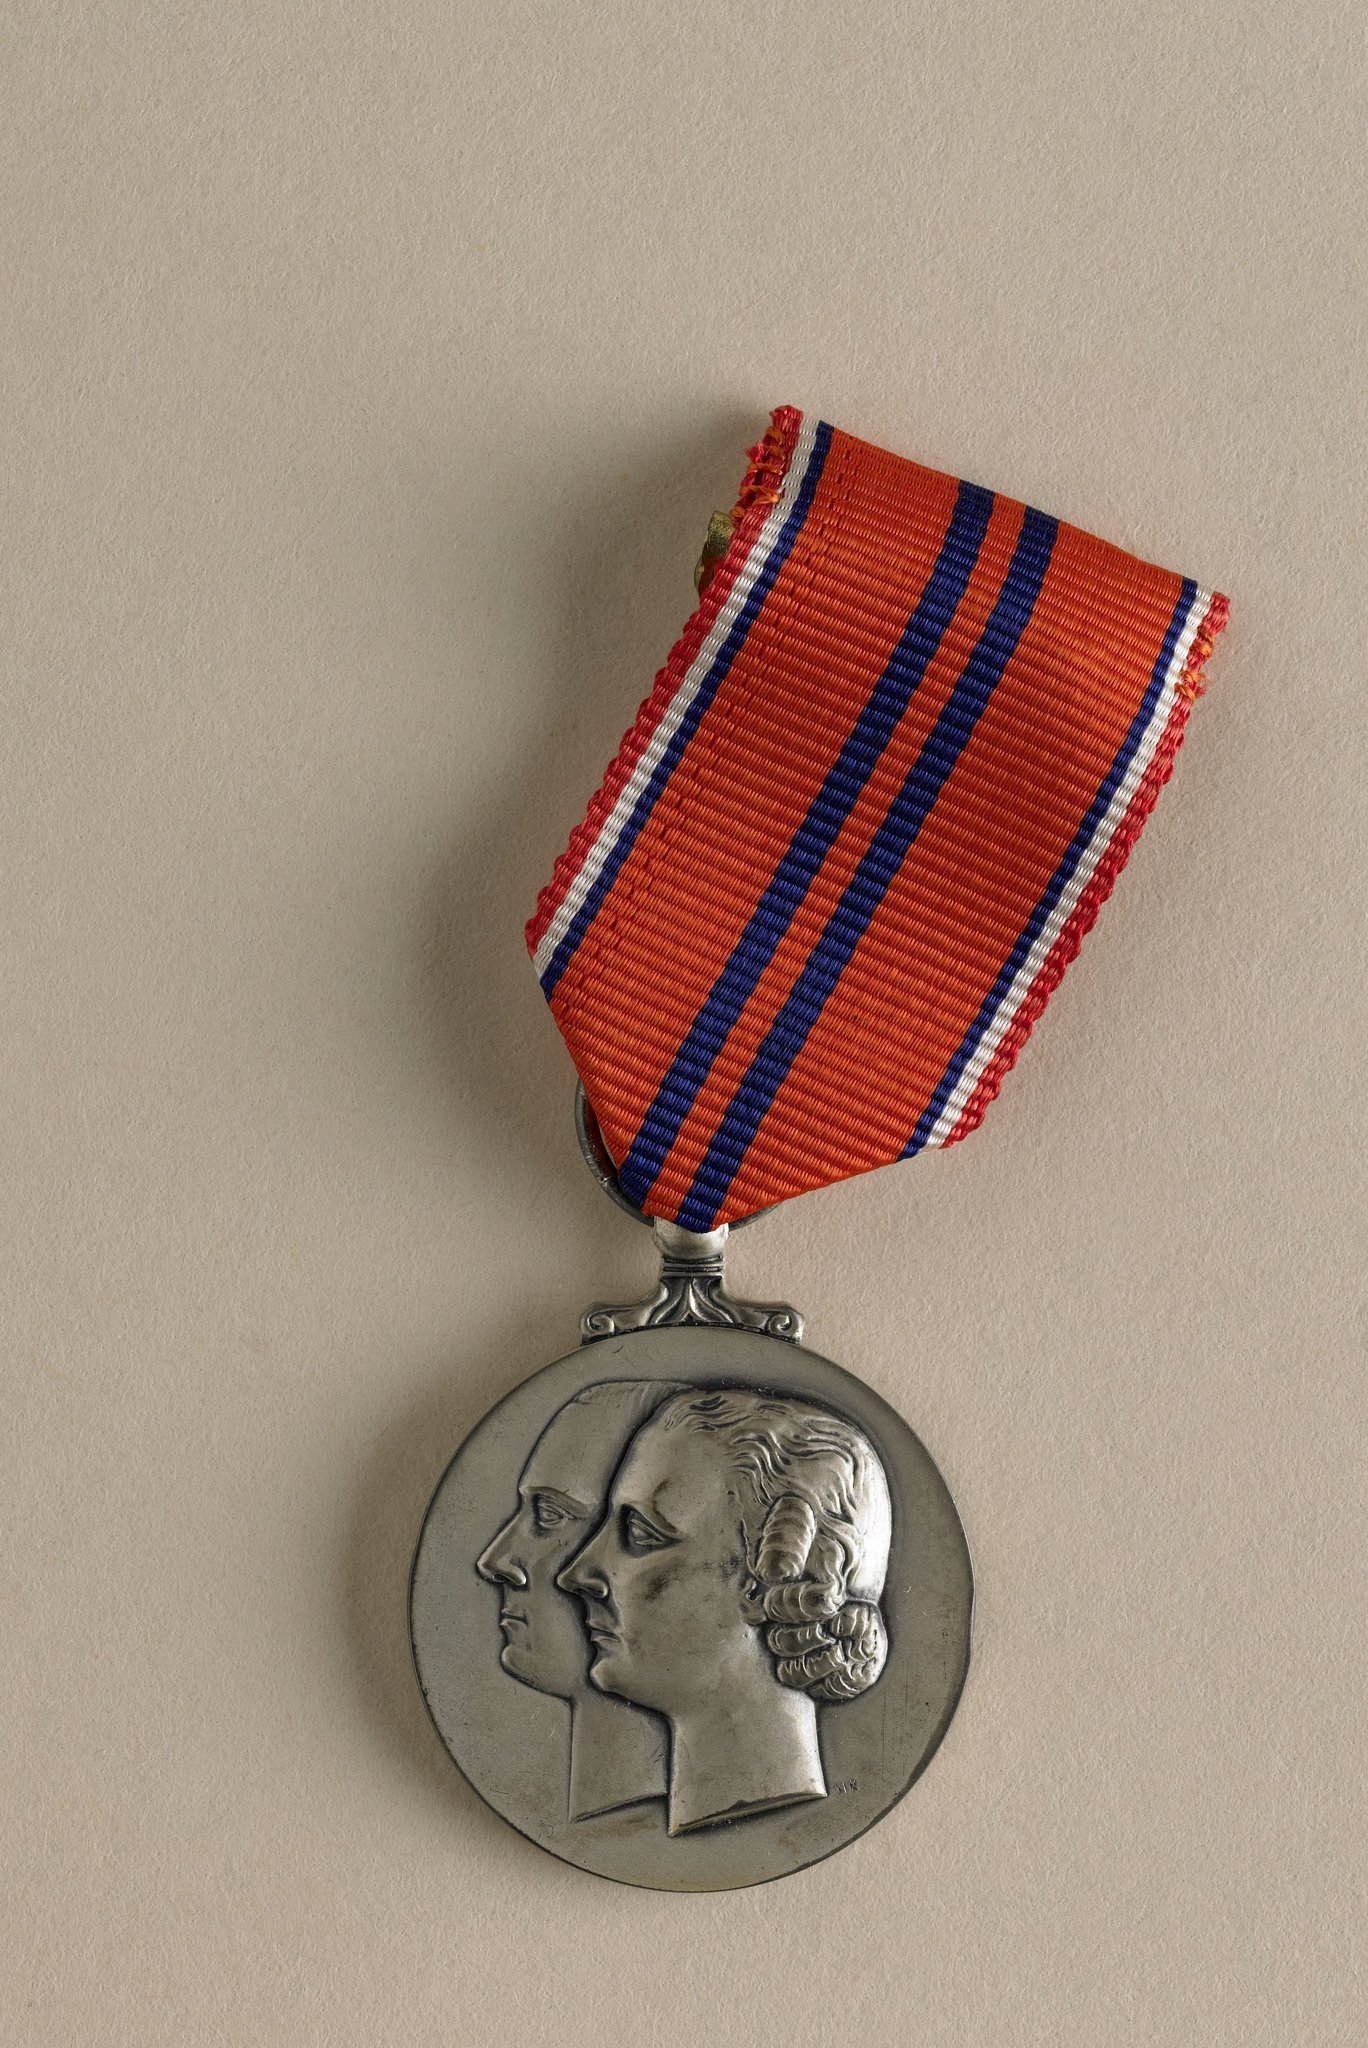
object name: onderscheidingsteken, onderscheiding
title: Inhuldigingsmedaille koningin Juliana 1948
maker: Anonymous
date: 1948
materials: cardboard, silver, textile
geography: netherlands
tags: utrecht, bernhard (prins der nederlanden), willem drees, the hague, juliana of the netherlands, netherlands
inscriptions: circumscription: ‘JULIANA KONINGIN DER NEDERLANDEN INHULDIGING 6 SEPTEMBER 1948’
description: Zilveren penning aan draagring en oranje lint met aan buitenzijde rood-wit-blauwe strepen en aan binnenzijde donkerblauwe streep, aan speld. Voorzijde: de hoofden van Juliana en Bernhard, met profiel naar links. Keerzijde: gekroonde J met omschrift.